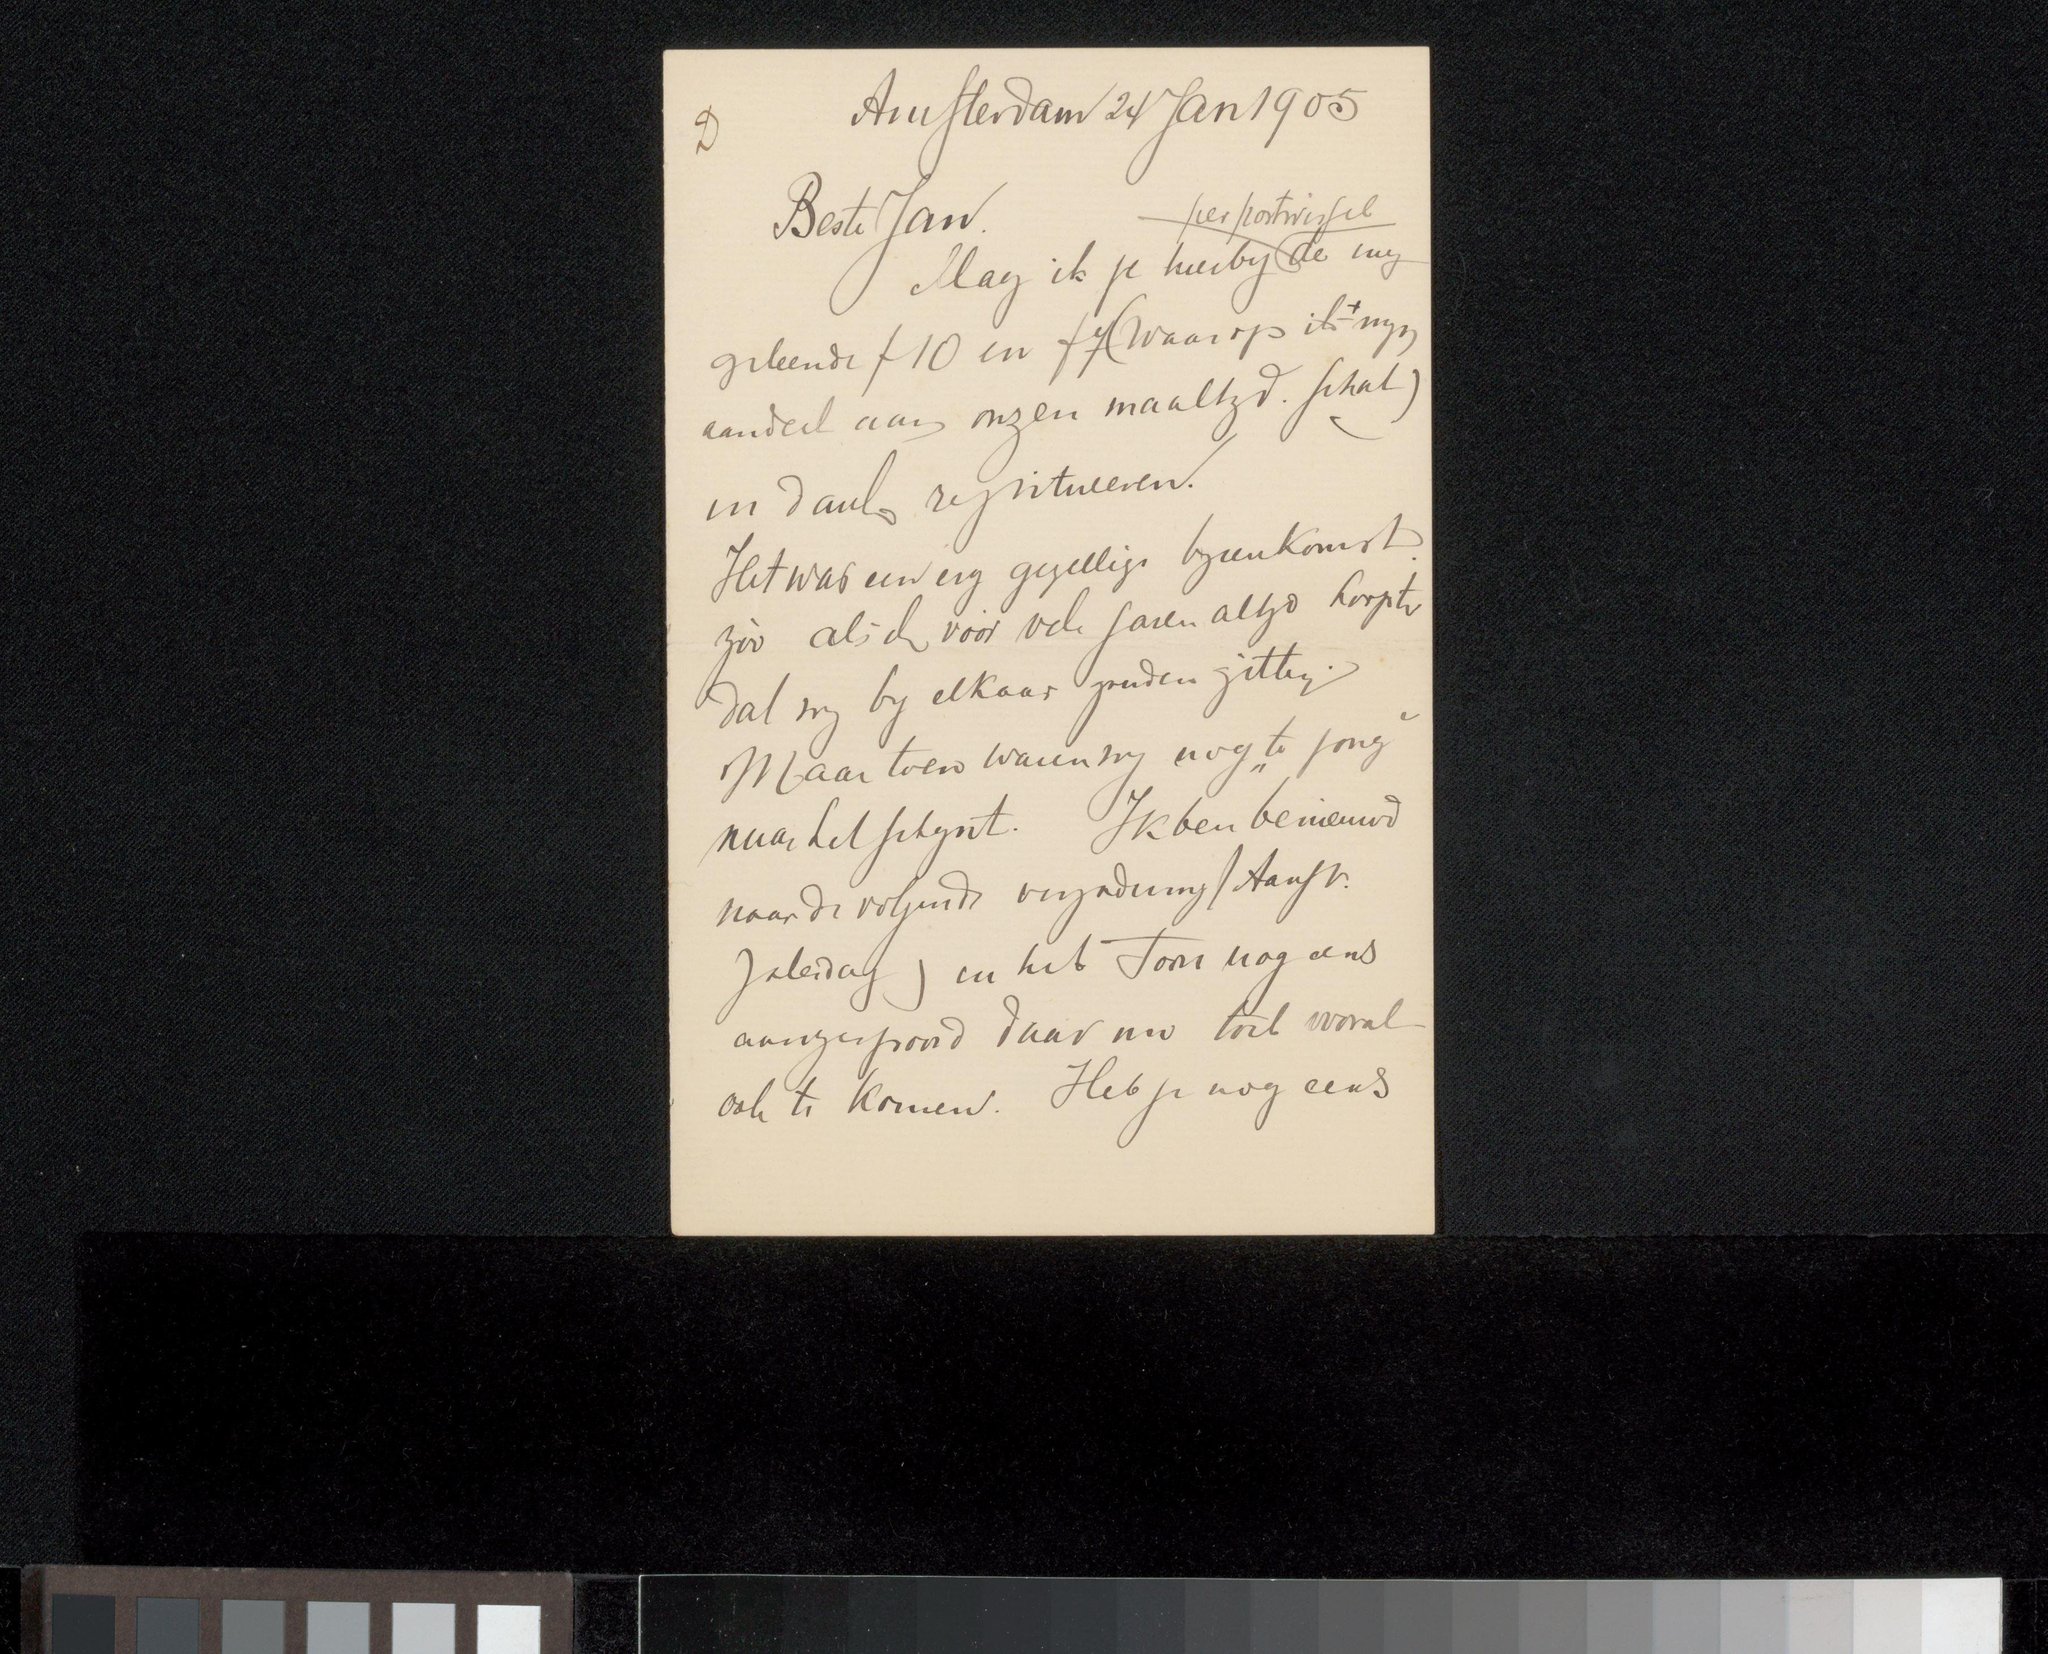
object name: letter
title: Brief aan Jan Veth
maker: alphons diepenbrock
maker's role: componist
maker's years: 1862-1921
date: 1905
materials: ink, paper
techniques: pen, writing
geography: amsterdam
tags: dordrecht, designer, jan veth, den bosch, antoon derkinderen, leiden, amsterdam, painter, print maker, draughtsman, rembrandt van rijn, music, literature ~ arts, money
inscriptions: collector's mark: ‘RPK’